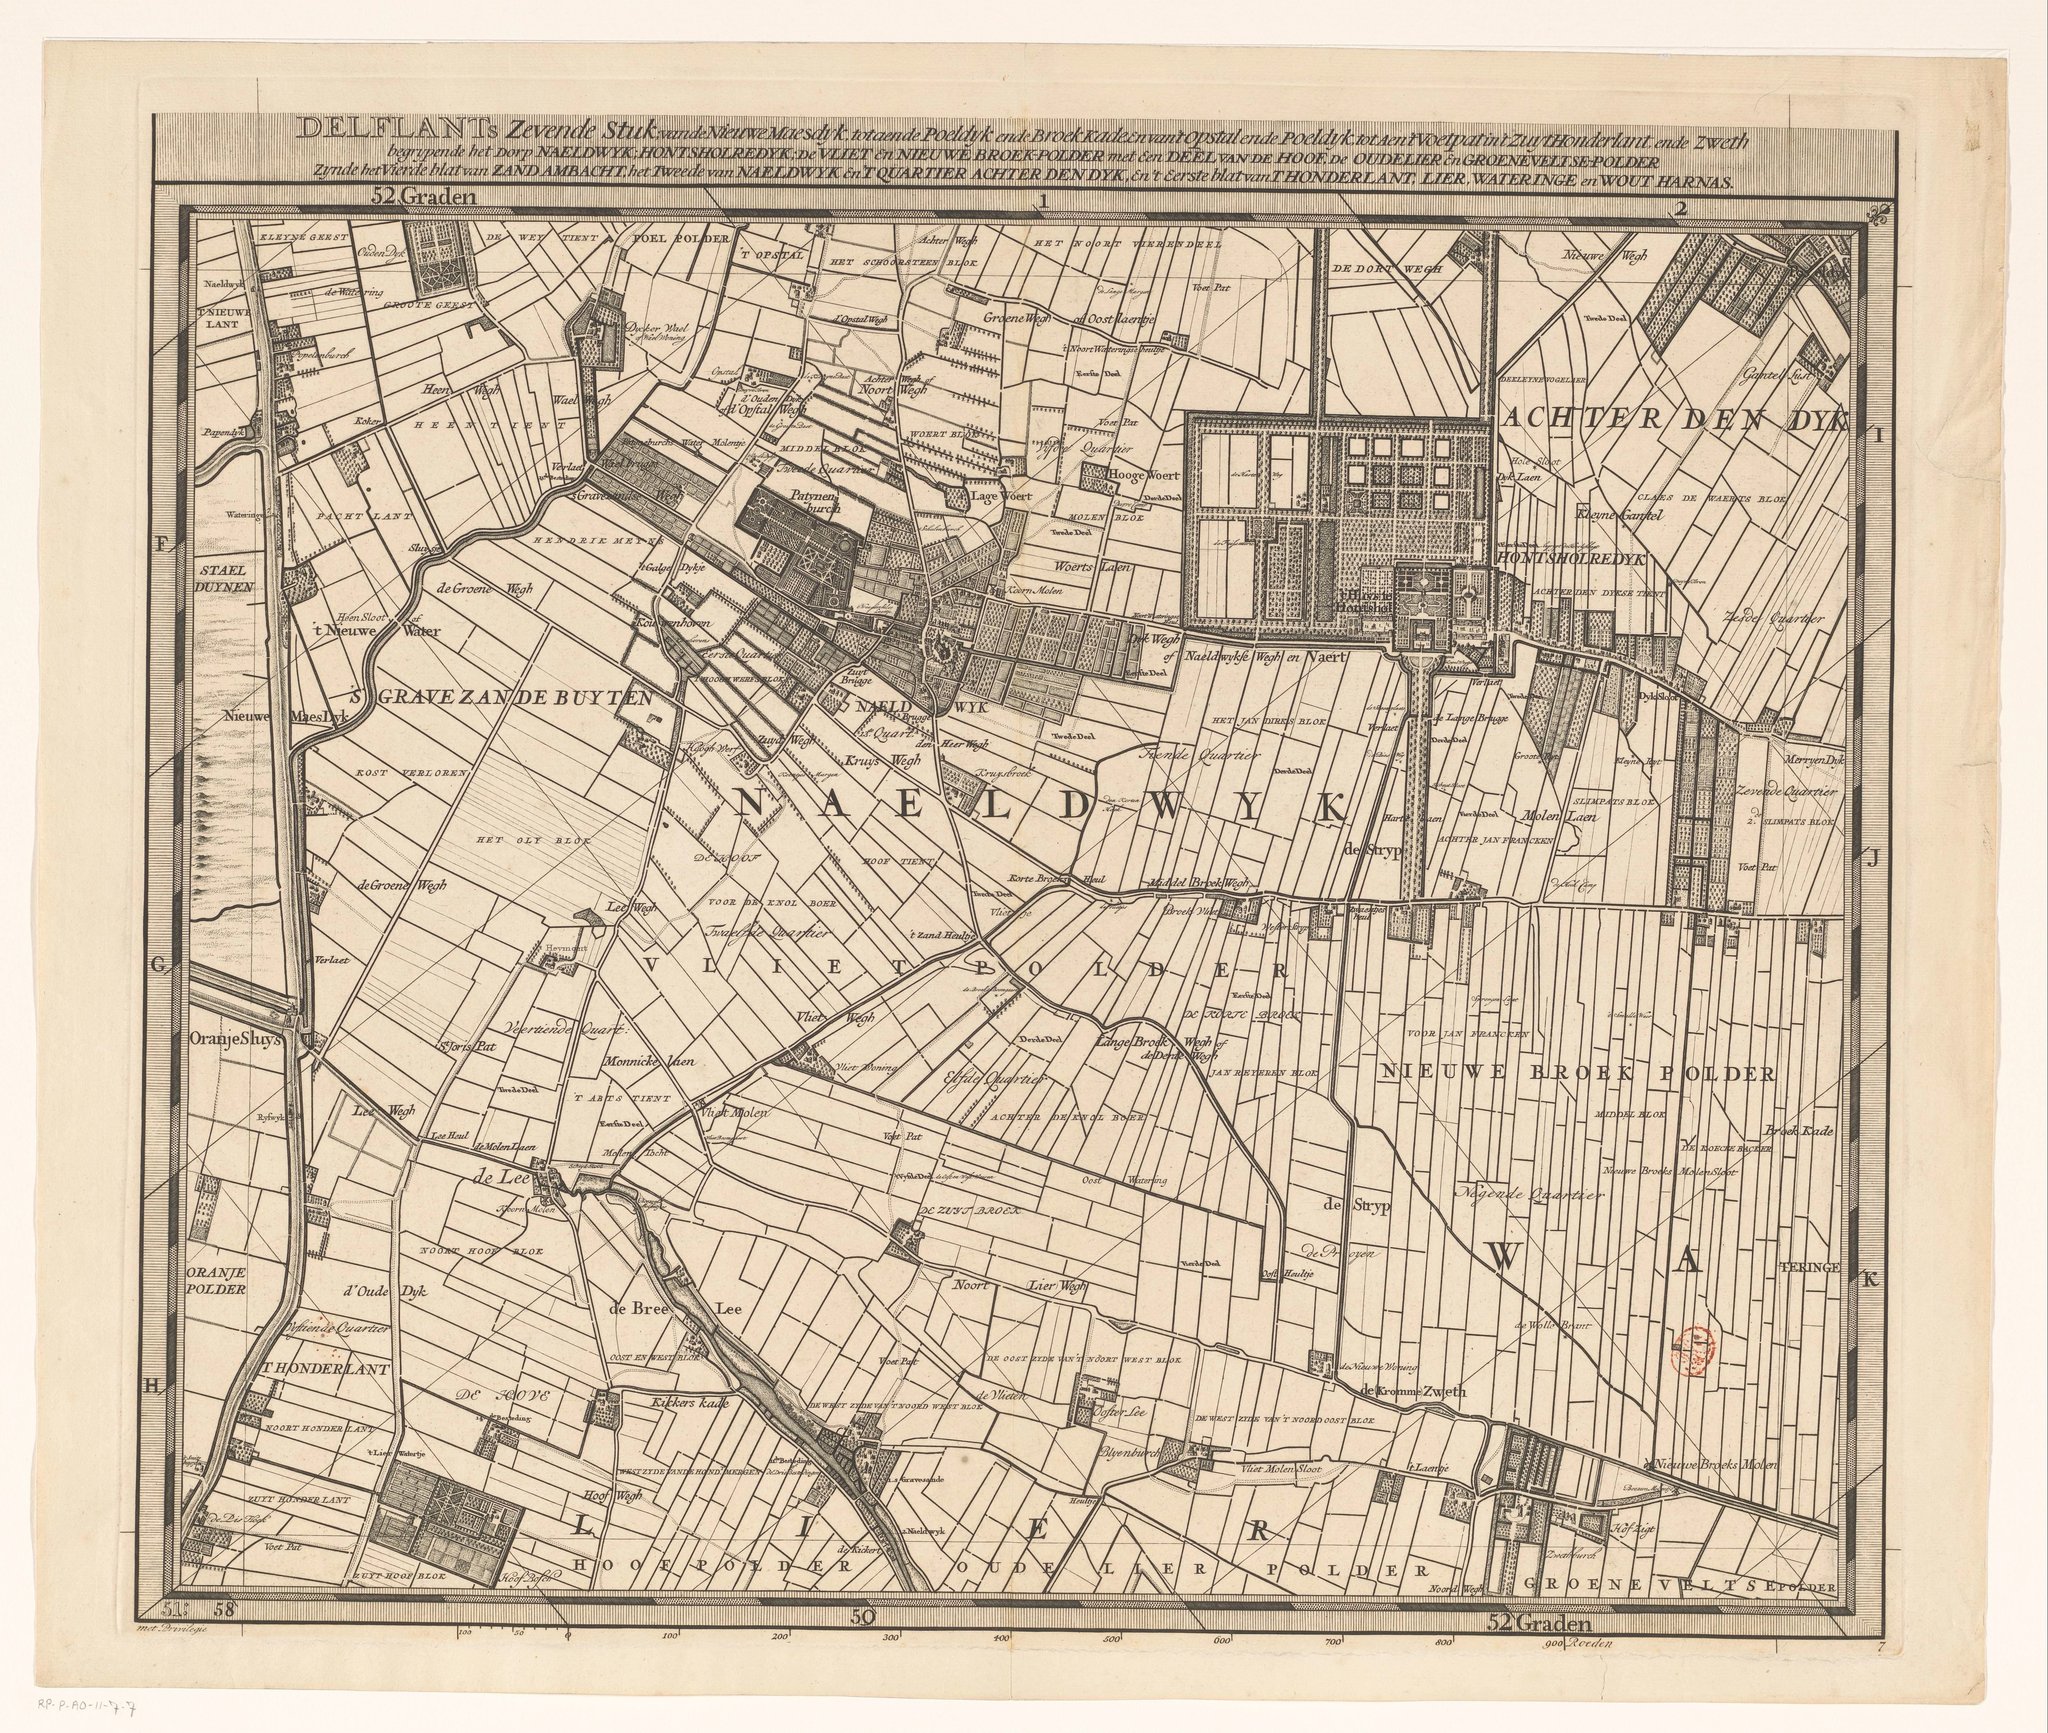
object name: print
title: 'T Hooge Heemraedschap van Delflant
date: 1712-1735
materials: paper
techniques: engraving, etching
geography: delft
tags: maps of cities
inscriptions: collector's mark: Lugt 195, collector's mark: Lugt 2228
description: Onderdeel van de grote wandkaart 'T Hooge Heemraedschap van Delflant. De kaart zelf bestaat uit vijfentwintig bladen, de titelstrook is gedrukt van twee platen. Meerdere prentmakers hebben aan deze kaart gewerkt. In volgorde van meest gewerkte dagen zijn dit: Luggert van Anse (1091 dagen), Thomas Doesburgh (952 dagen), Jacobus Deur (806 dagen), Johannes Deur (683 dagen) en Pieter Sluyter (151 dagen). Sluyter was verantwoordelijk voor de versieringen, de anderen voor de rest. Wie precies aan welk blad heeft gewerkt is niet duidelijk. Pieter Haringh had het ontwerp voor de wapenschilden geleverd en Arnold Houbraken het ontwerp voor de rest van de versieringen. Het drukken, uitgeven en verkopen van de kaart lag, zoals blijkt uit het privilege, in handen van het hoogheemraadschap. Voor zover bekend is de kaart in zijn geheel twee keer gedrukt, in 1712 en 1735. Het hoogheemraadschap beheerde de voorraad kaarten voor verkoop. In een aantal atlassen van Covens & Mortier (Nieuwe atlas inhoudende de vier gedeeltens der waereld (...). 5 delen. Amsterdam: Covens & Mortier, s.a. [1721-1759], dl. 3) zijn de zevenentwintig bladen van de kaart en de overzichtskaart opgenomen. Het is dus vermoedelijk niet zo dat de kaart voor deze atlassen opnieuw werd gedrukt. Waarschijnlijk werd een aantal exemplaren bij het hoogheemraadschap afgenomen.